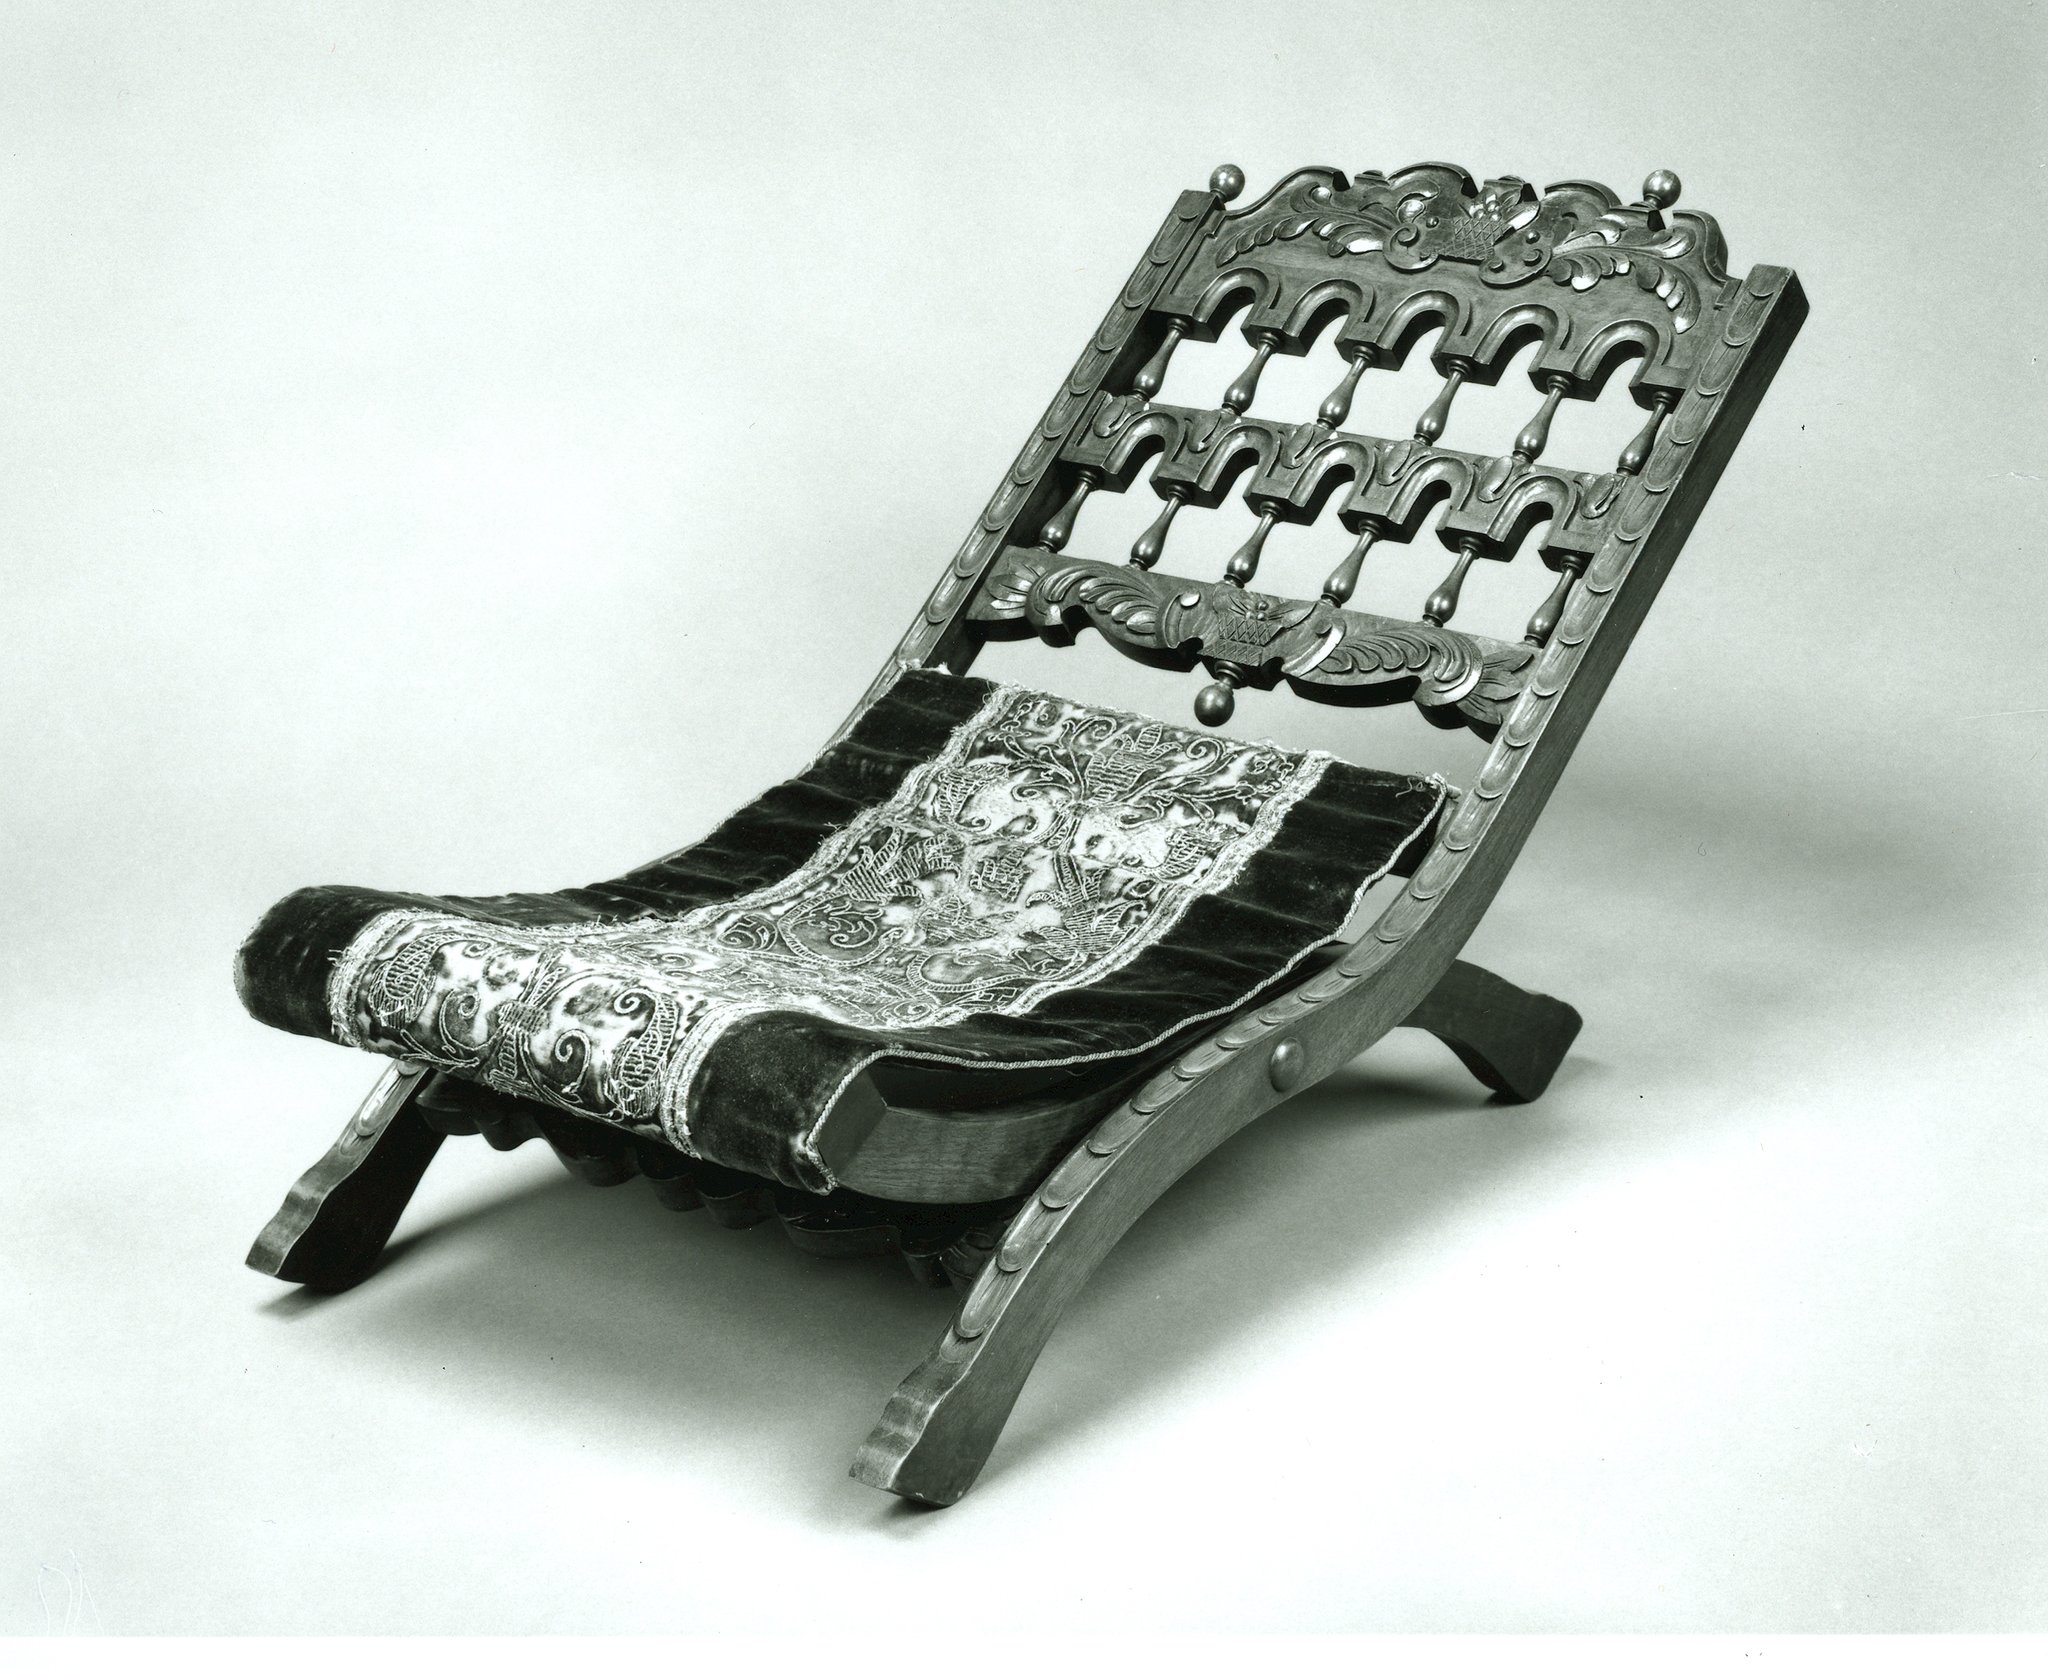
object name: chair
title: Collapsible Chair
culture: american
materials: gilt, metal, silk, velvet, wood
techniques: cutting, embroidery